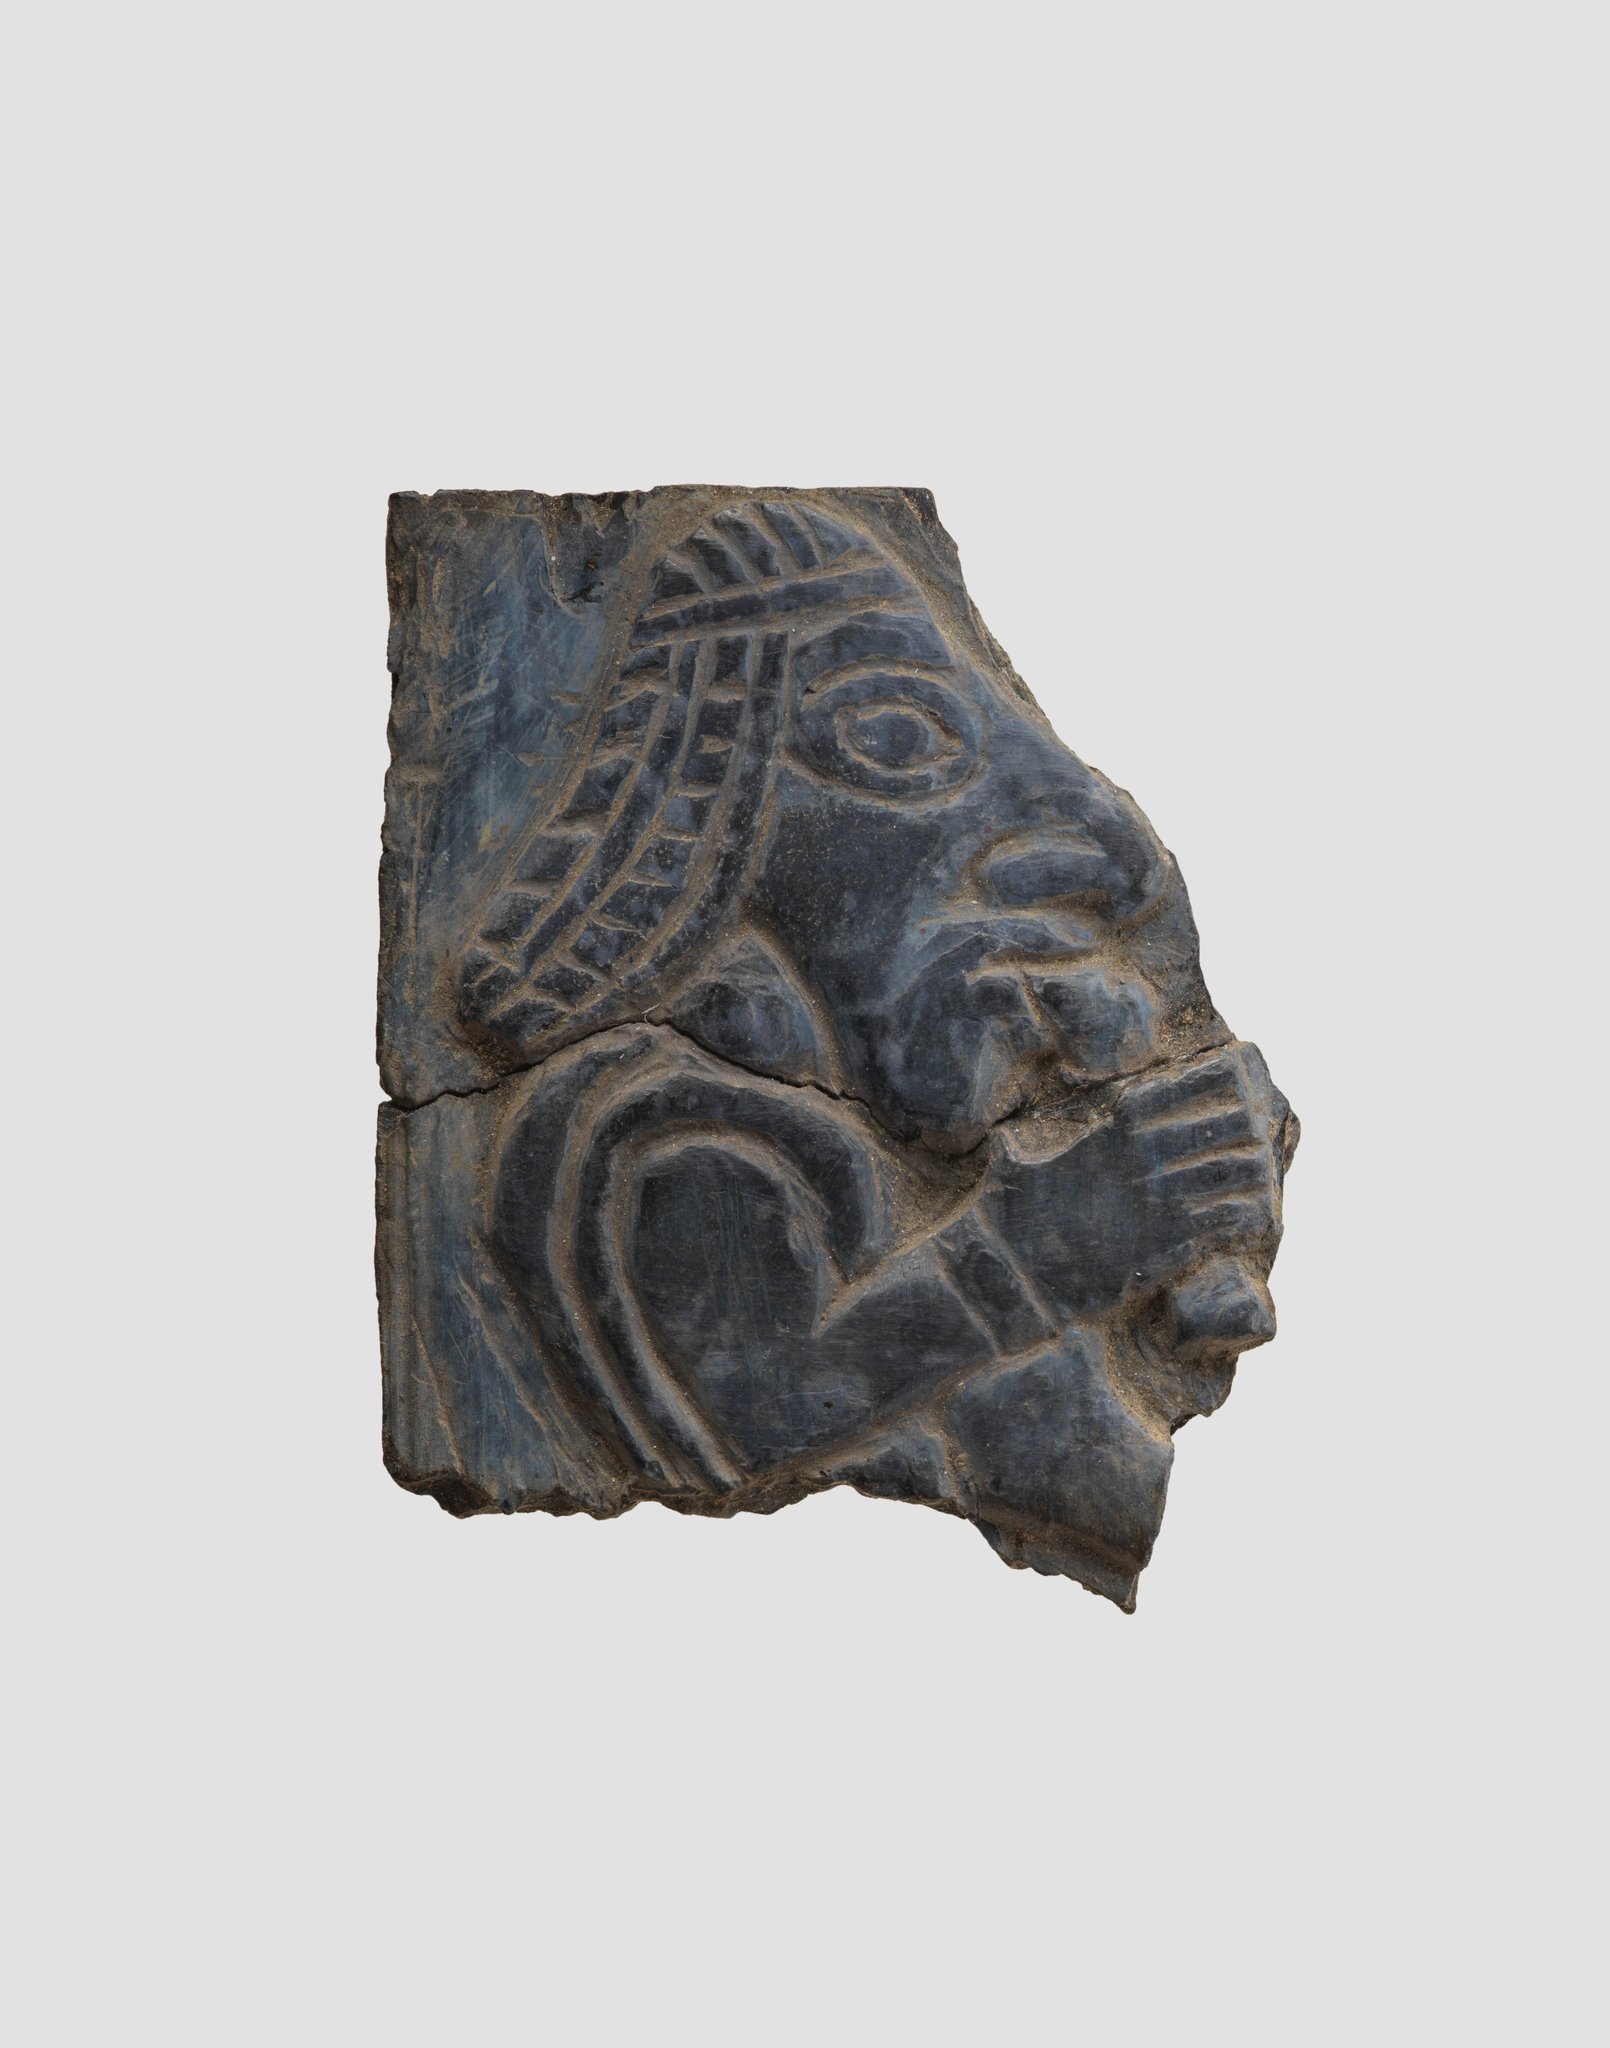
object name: relief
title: Furniture plaque carved in relief with man holding vessel to his mouth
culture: iranian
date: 900-801 BCE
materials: ivory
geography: iran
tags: men